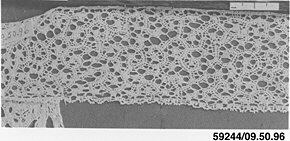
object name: strip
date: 1701-1800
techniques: lace